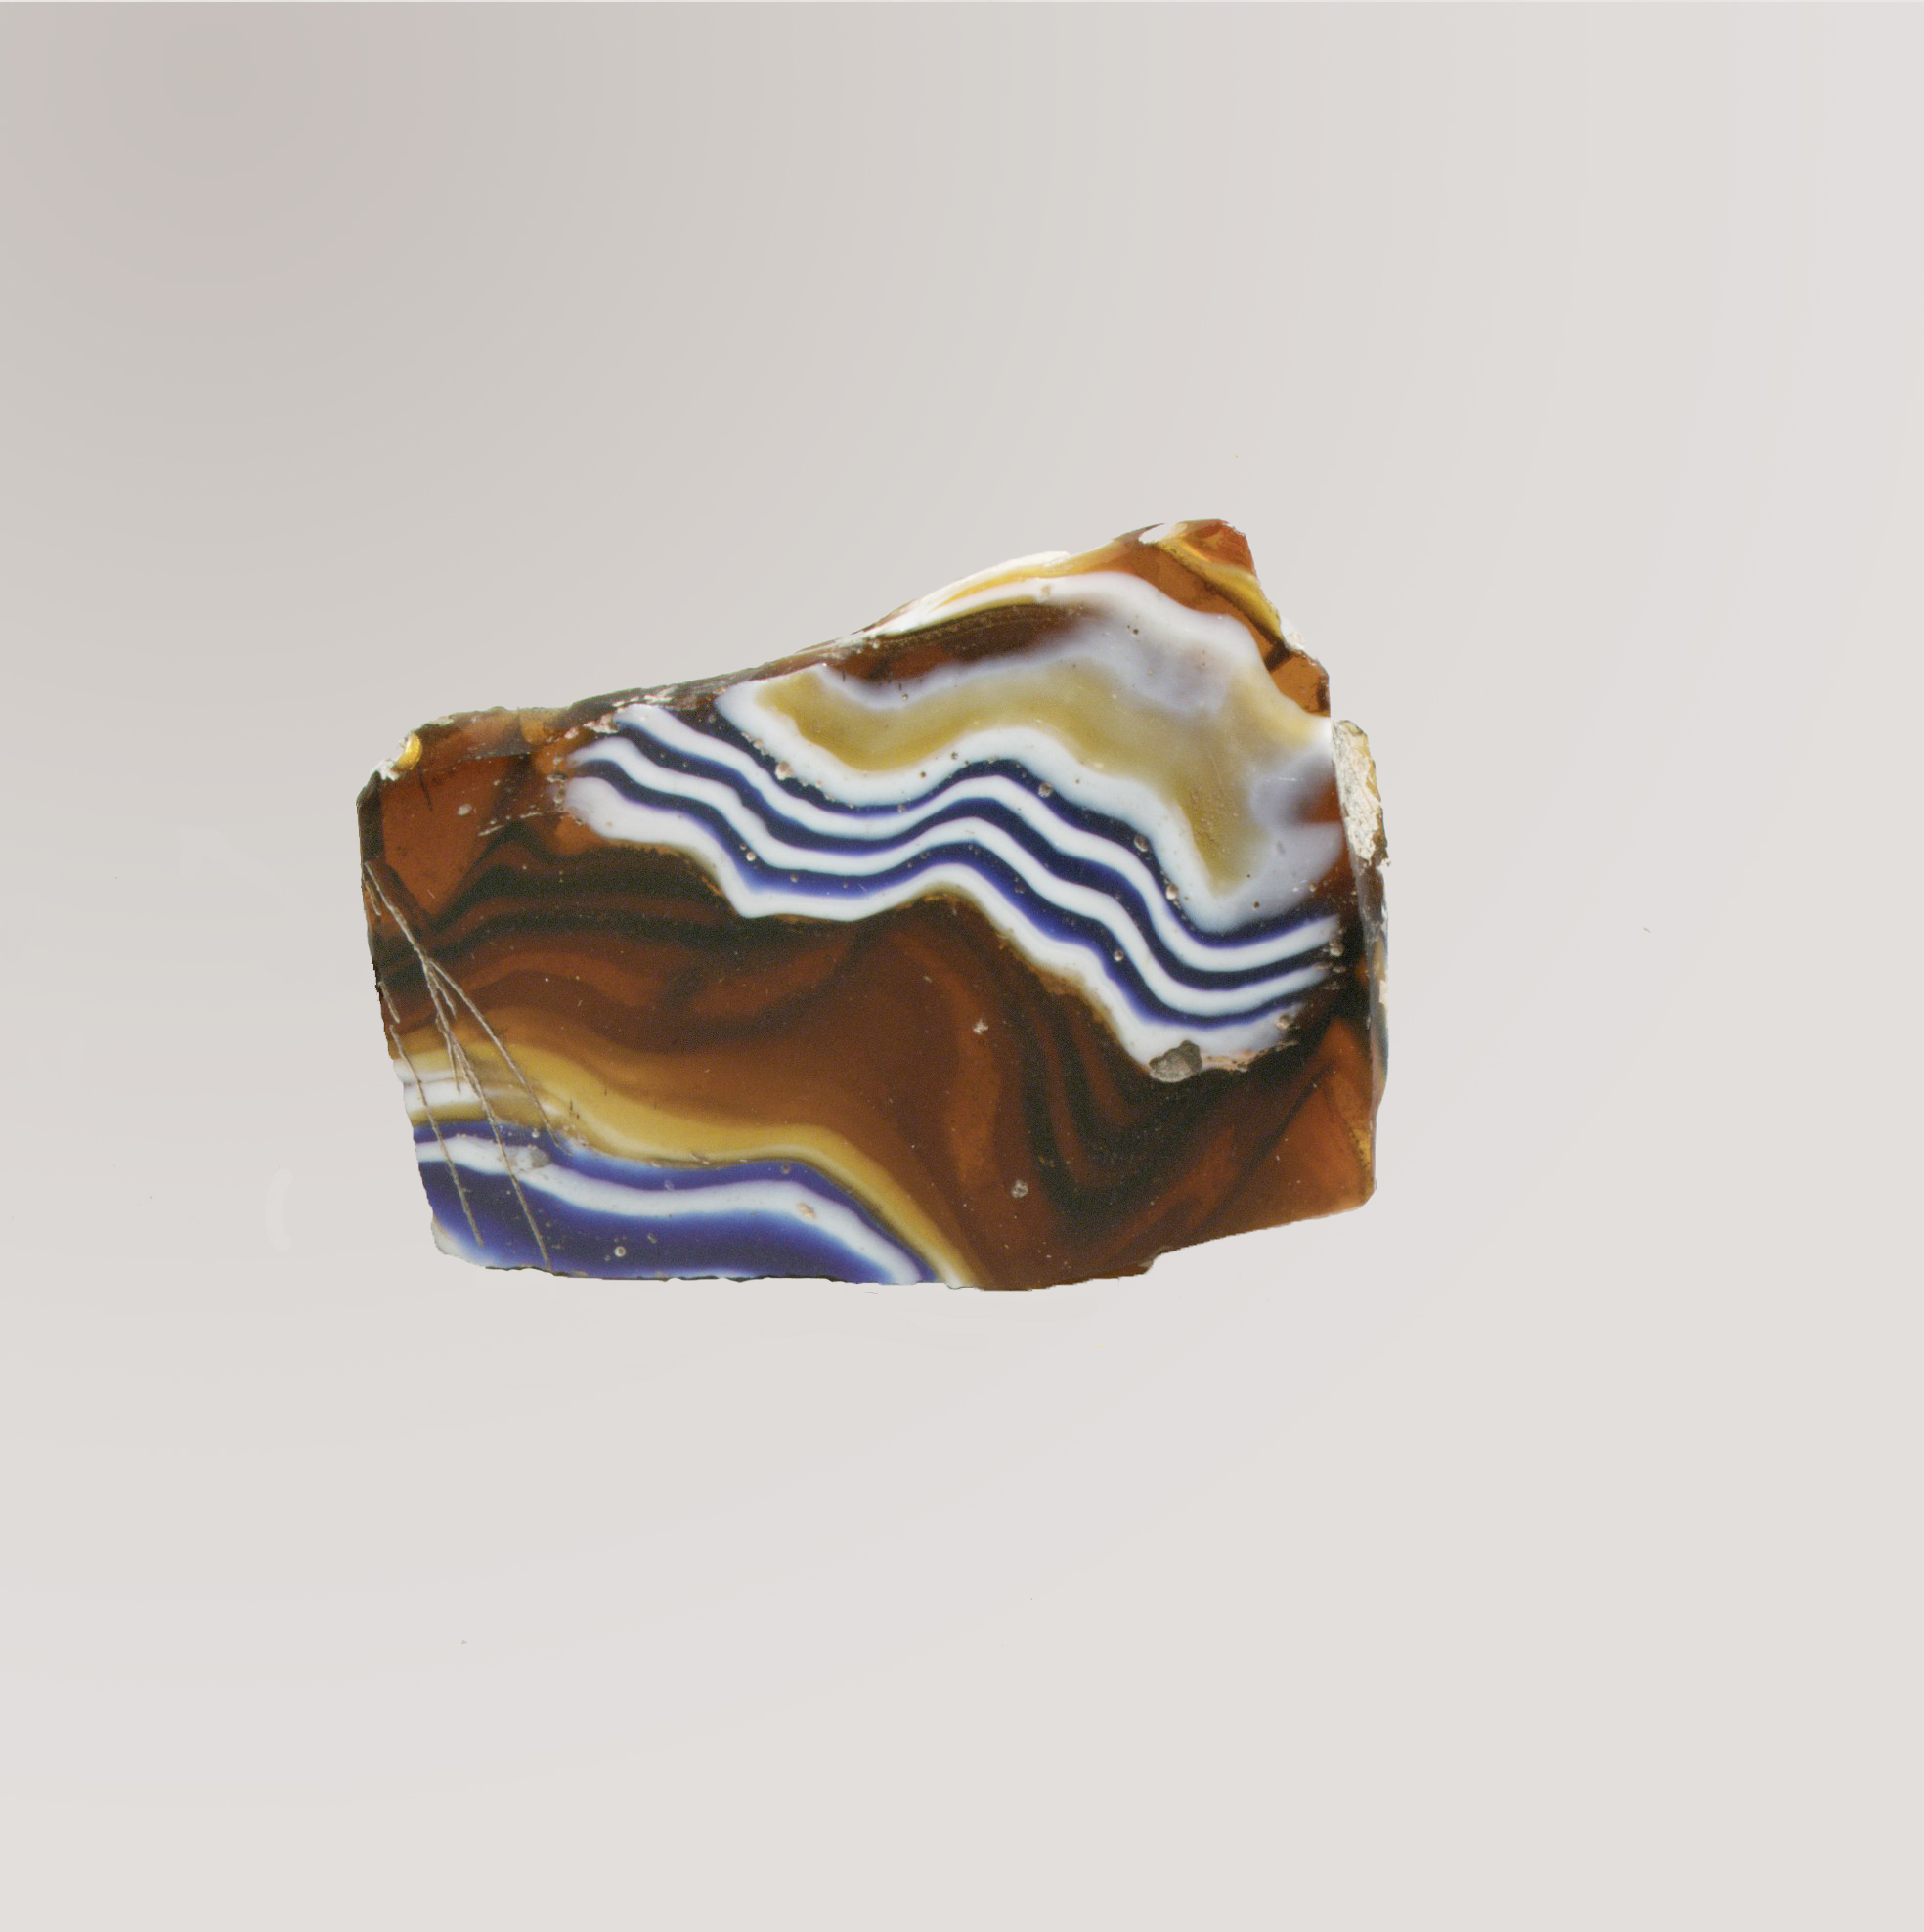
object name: fragment, mosaic bowl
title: Glass mosaic ribbed bowl fragment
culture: roman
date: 34 BCE-33 CE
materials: glass